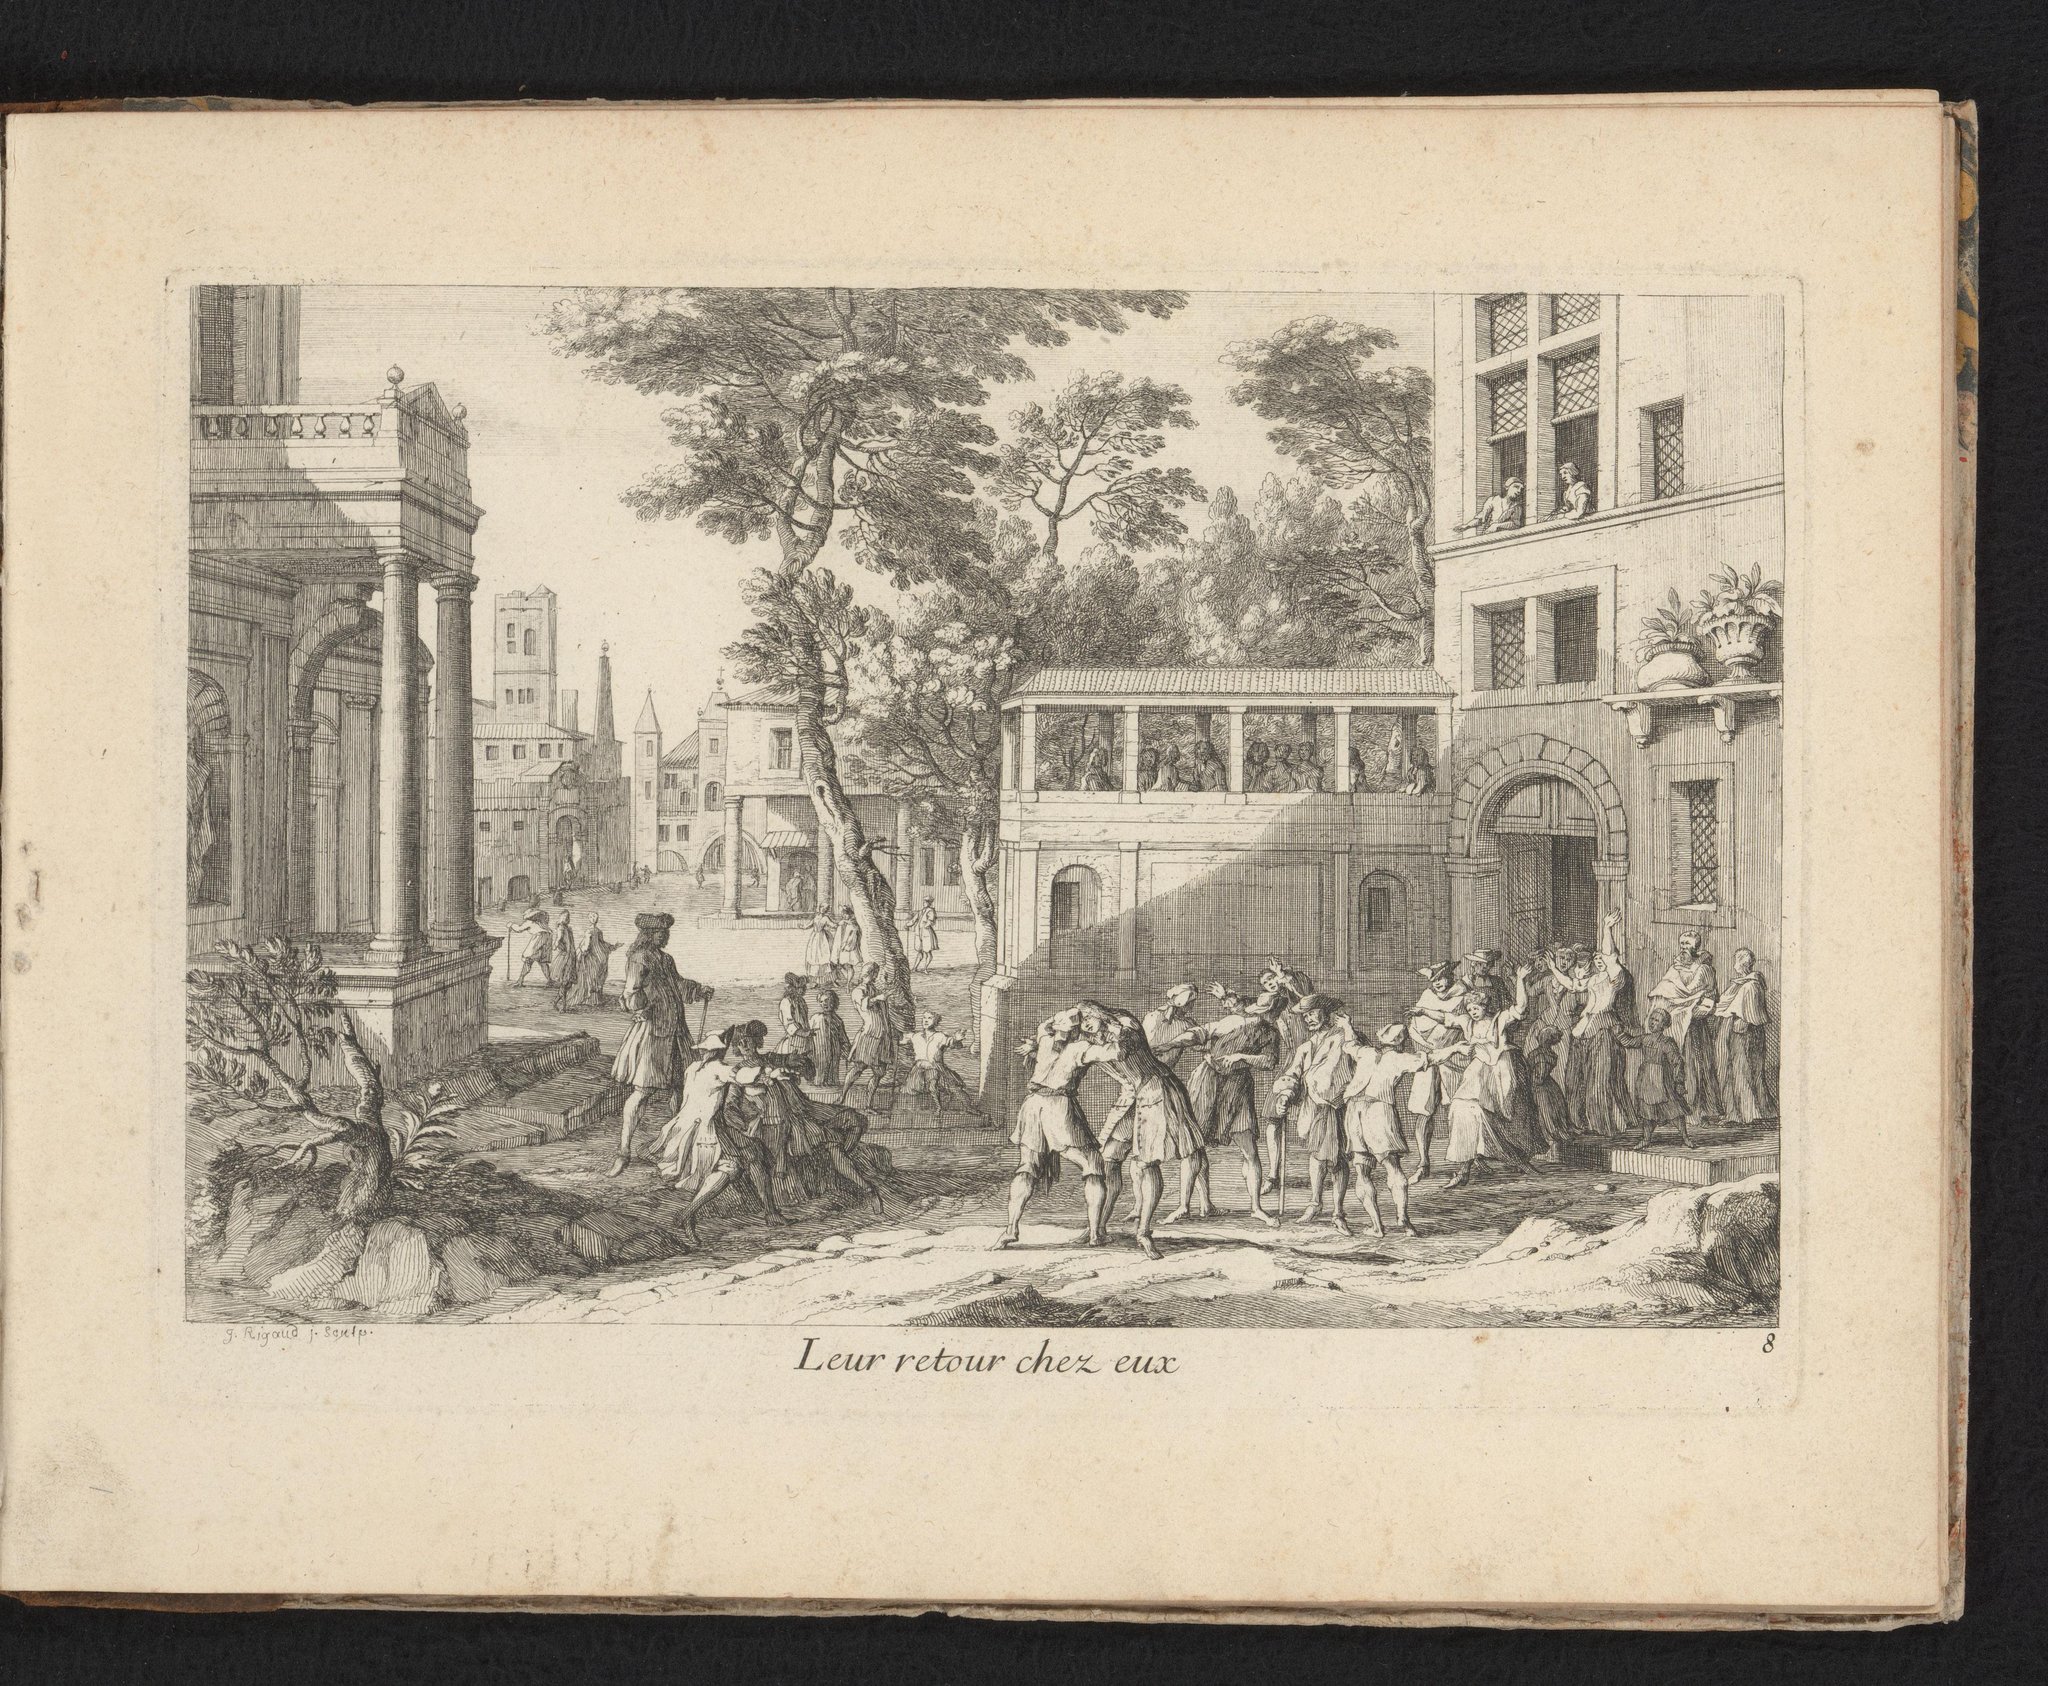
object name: album leaf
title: Landschappen en zeegezichten met de lotgevallen van reizigers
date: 1700-1725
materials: paper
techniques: etching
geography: paris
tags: city-view in general; 'veduta', arrival and return ~ travelling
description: Deze prent maakt deel uit van een album.